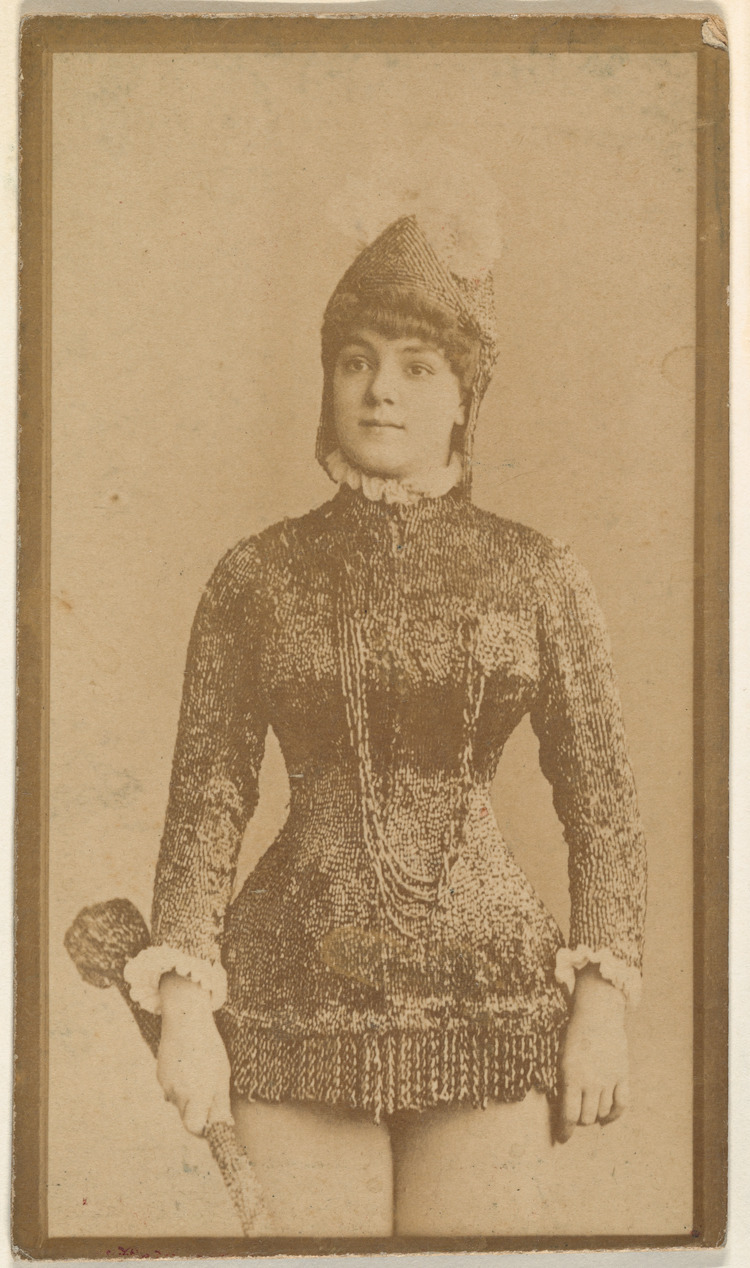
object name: photograph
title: Actress wearing military-inspired costume, from the Actresses series (N668)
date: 1888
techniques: albumen silver print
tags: portraits,women,actresses